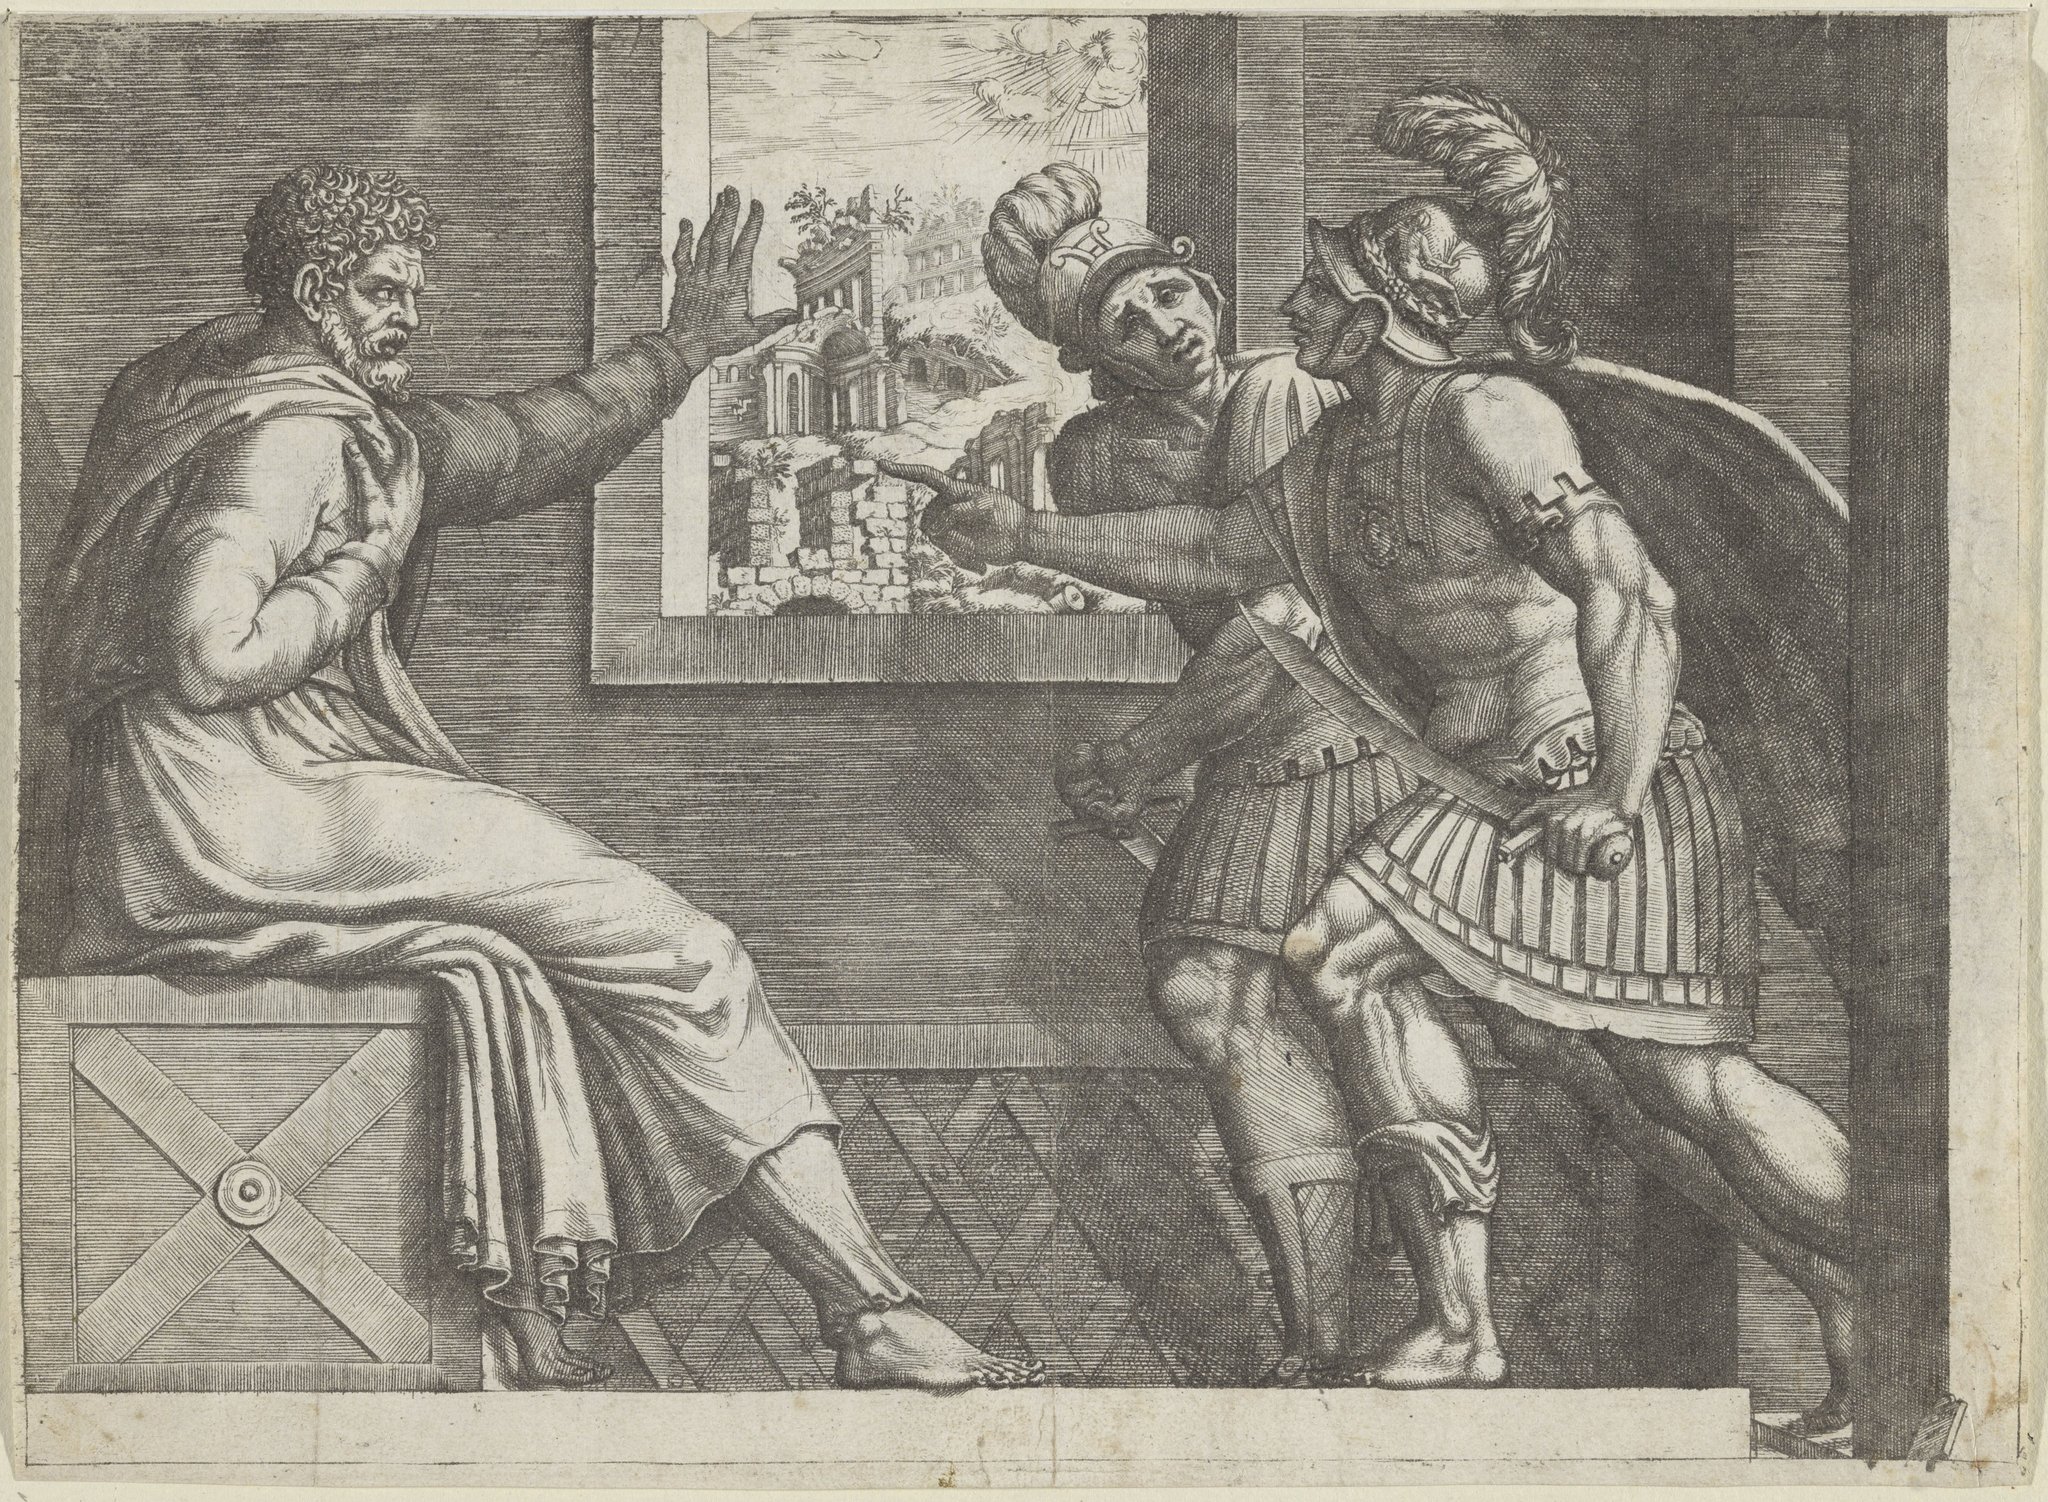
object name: print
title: Gaius Marius in de gevangenis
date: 1530-1582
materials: paper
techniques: printmaking, engraving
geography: italy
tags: prison, jail, commander-in-chief, general, marshal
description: De Romeinse generaal Gaius Marius in gesprek met twee gevangenisbewaarders, in de gevangenis te Minturno. Door een venster is een landschap met ruïnes zichtbaar.